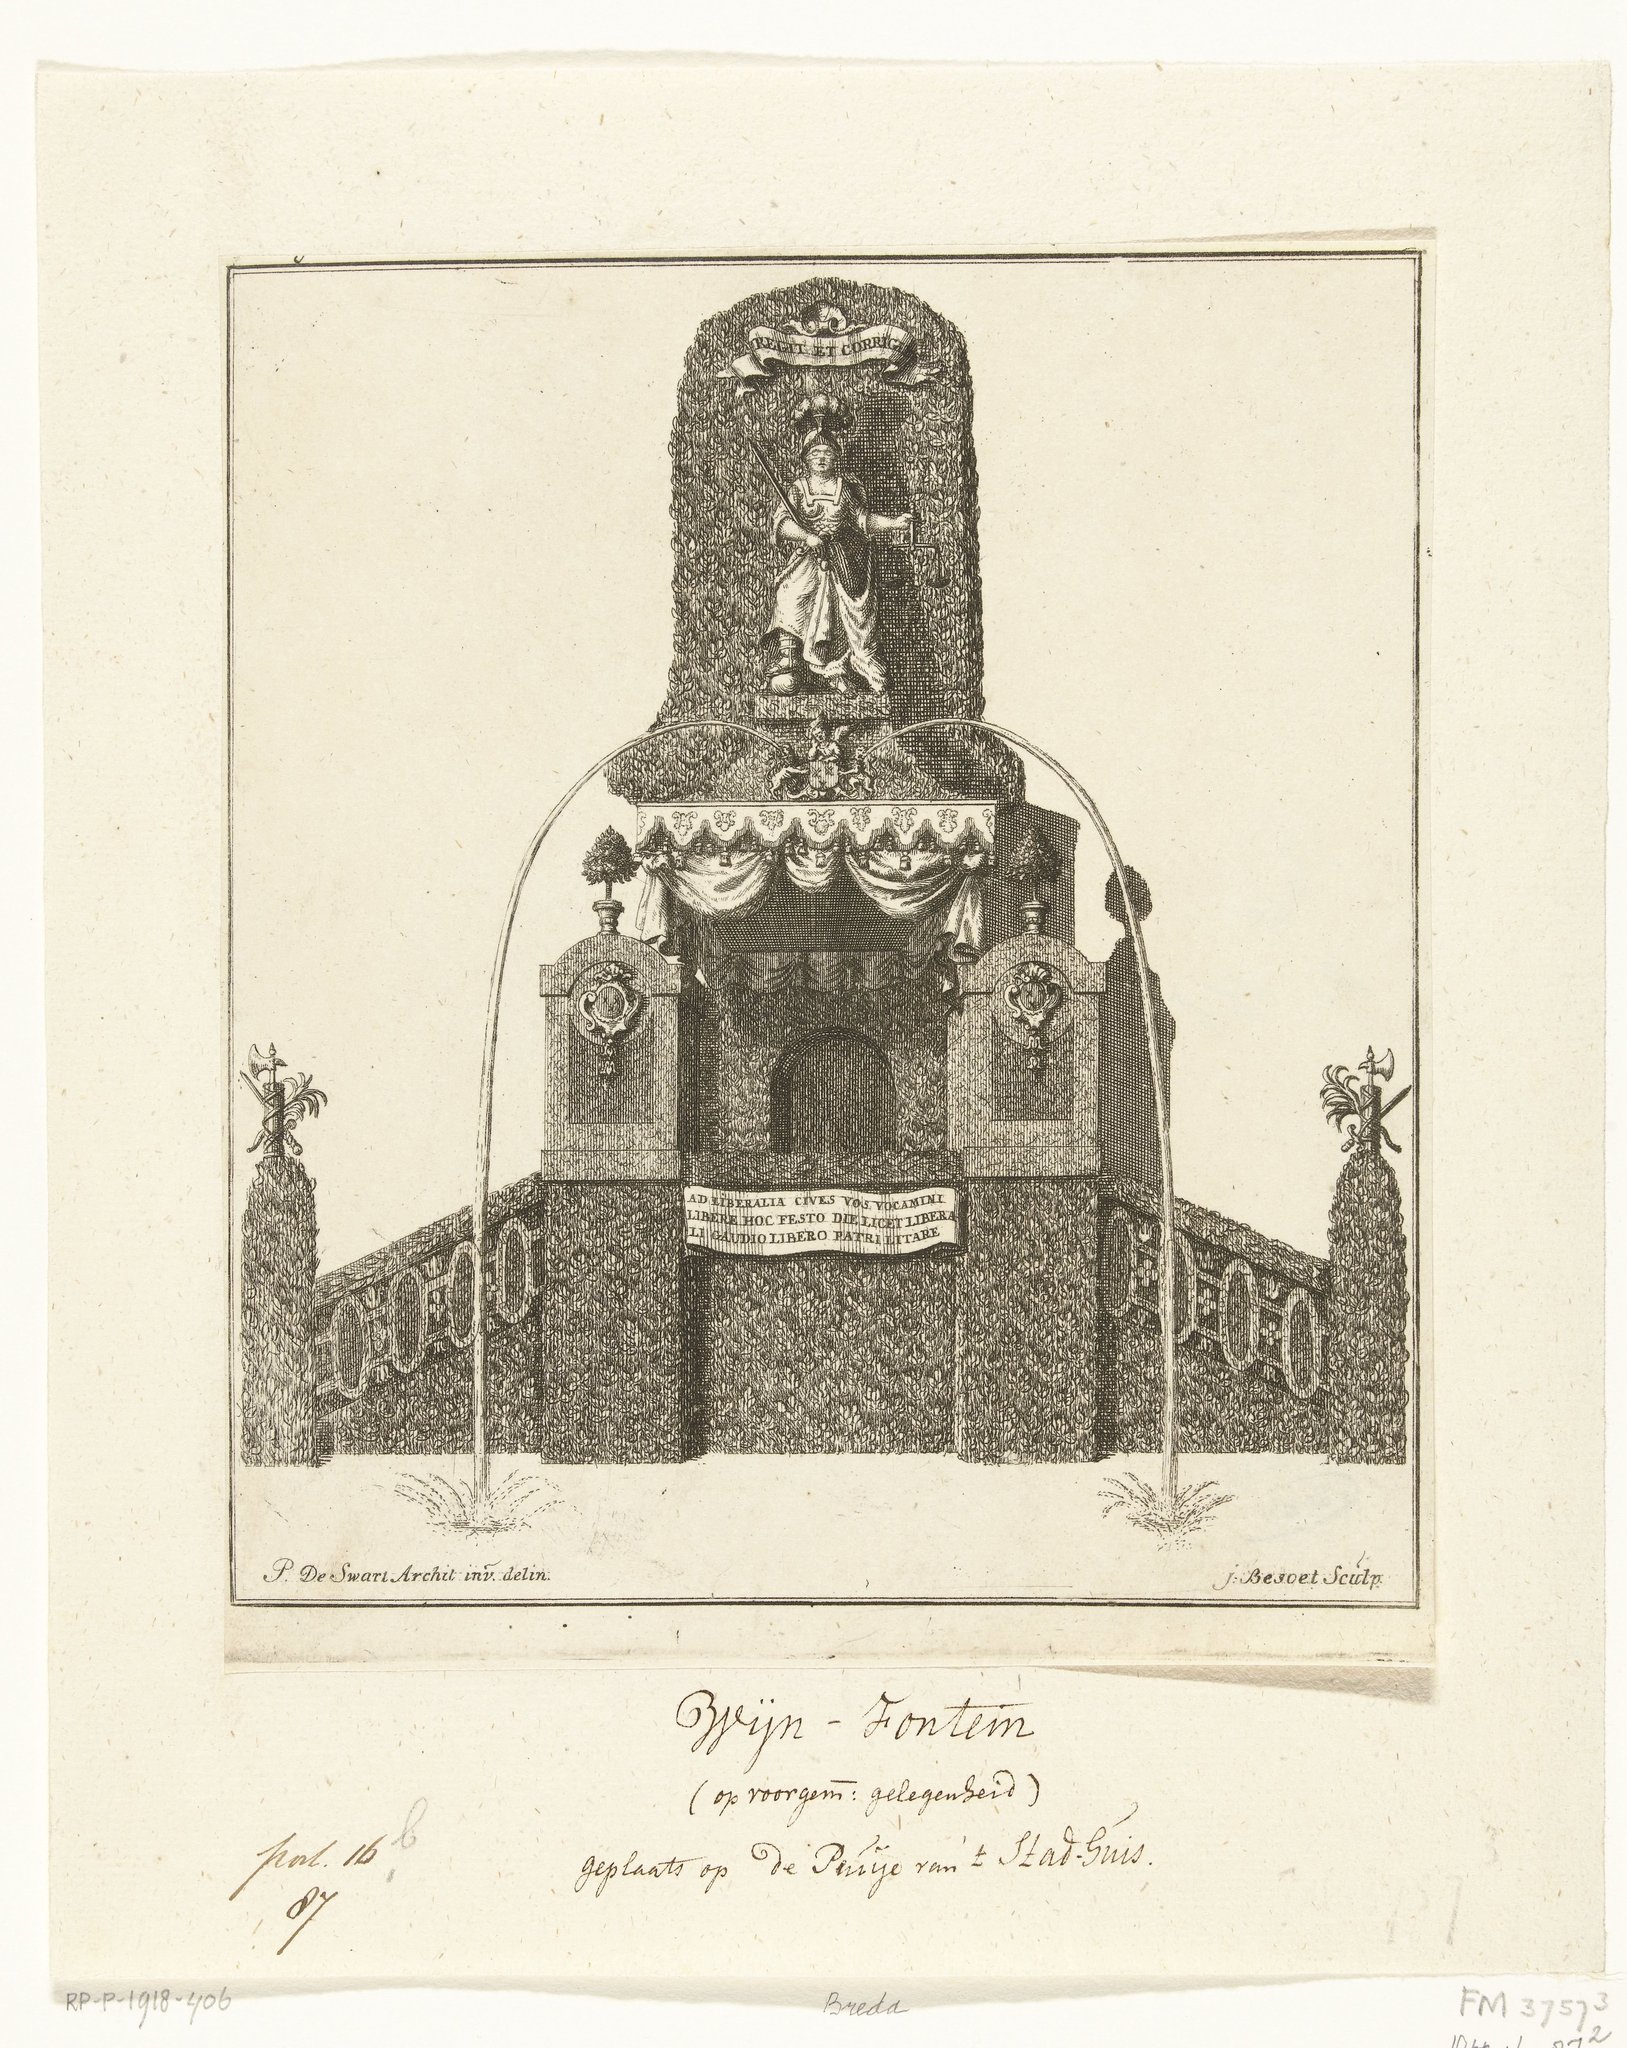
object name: print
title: Fontein voor de gevel van het stadhuis bij de intrede van Willem IV en zijn gemalin te Breda op 13 september 1737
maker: iven besoet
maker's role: print maker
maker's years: 1720-1769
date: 1737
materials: paper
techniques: engraving, etching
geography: the hague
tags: ornamental fountain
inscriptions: collector's mark: Lugt 2228, inscription: ‘port 16/ 87’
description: Fontein voor de gevel van het stadhuis bij de intrede van Willem IV en zijn gemalin te Breda op 13 september 1737. Op dit ontwerp van hofarchitect Pieter de Swart staat een beeld van Justitia.